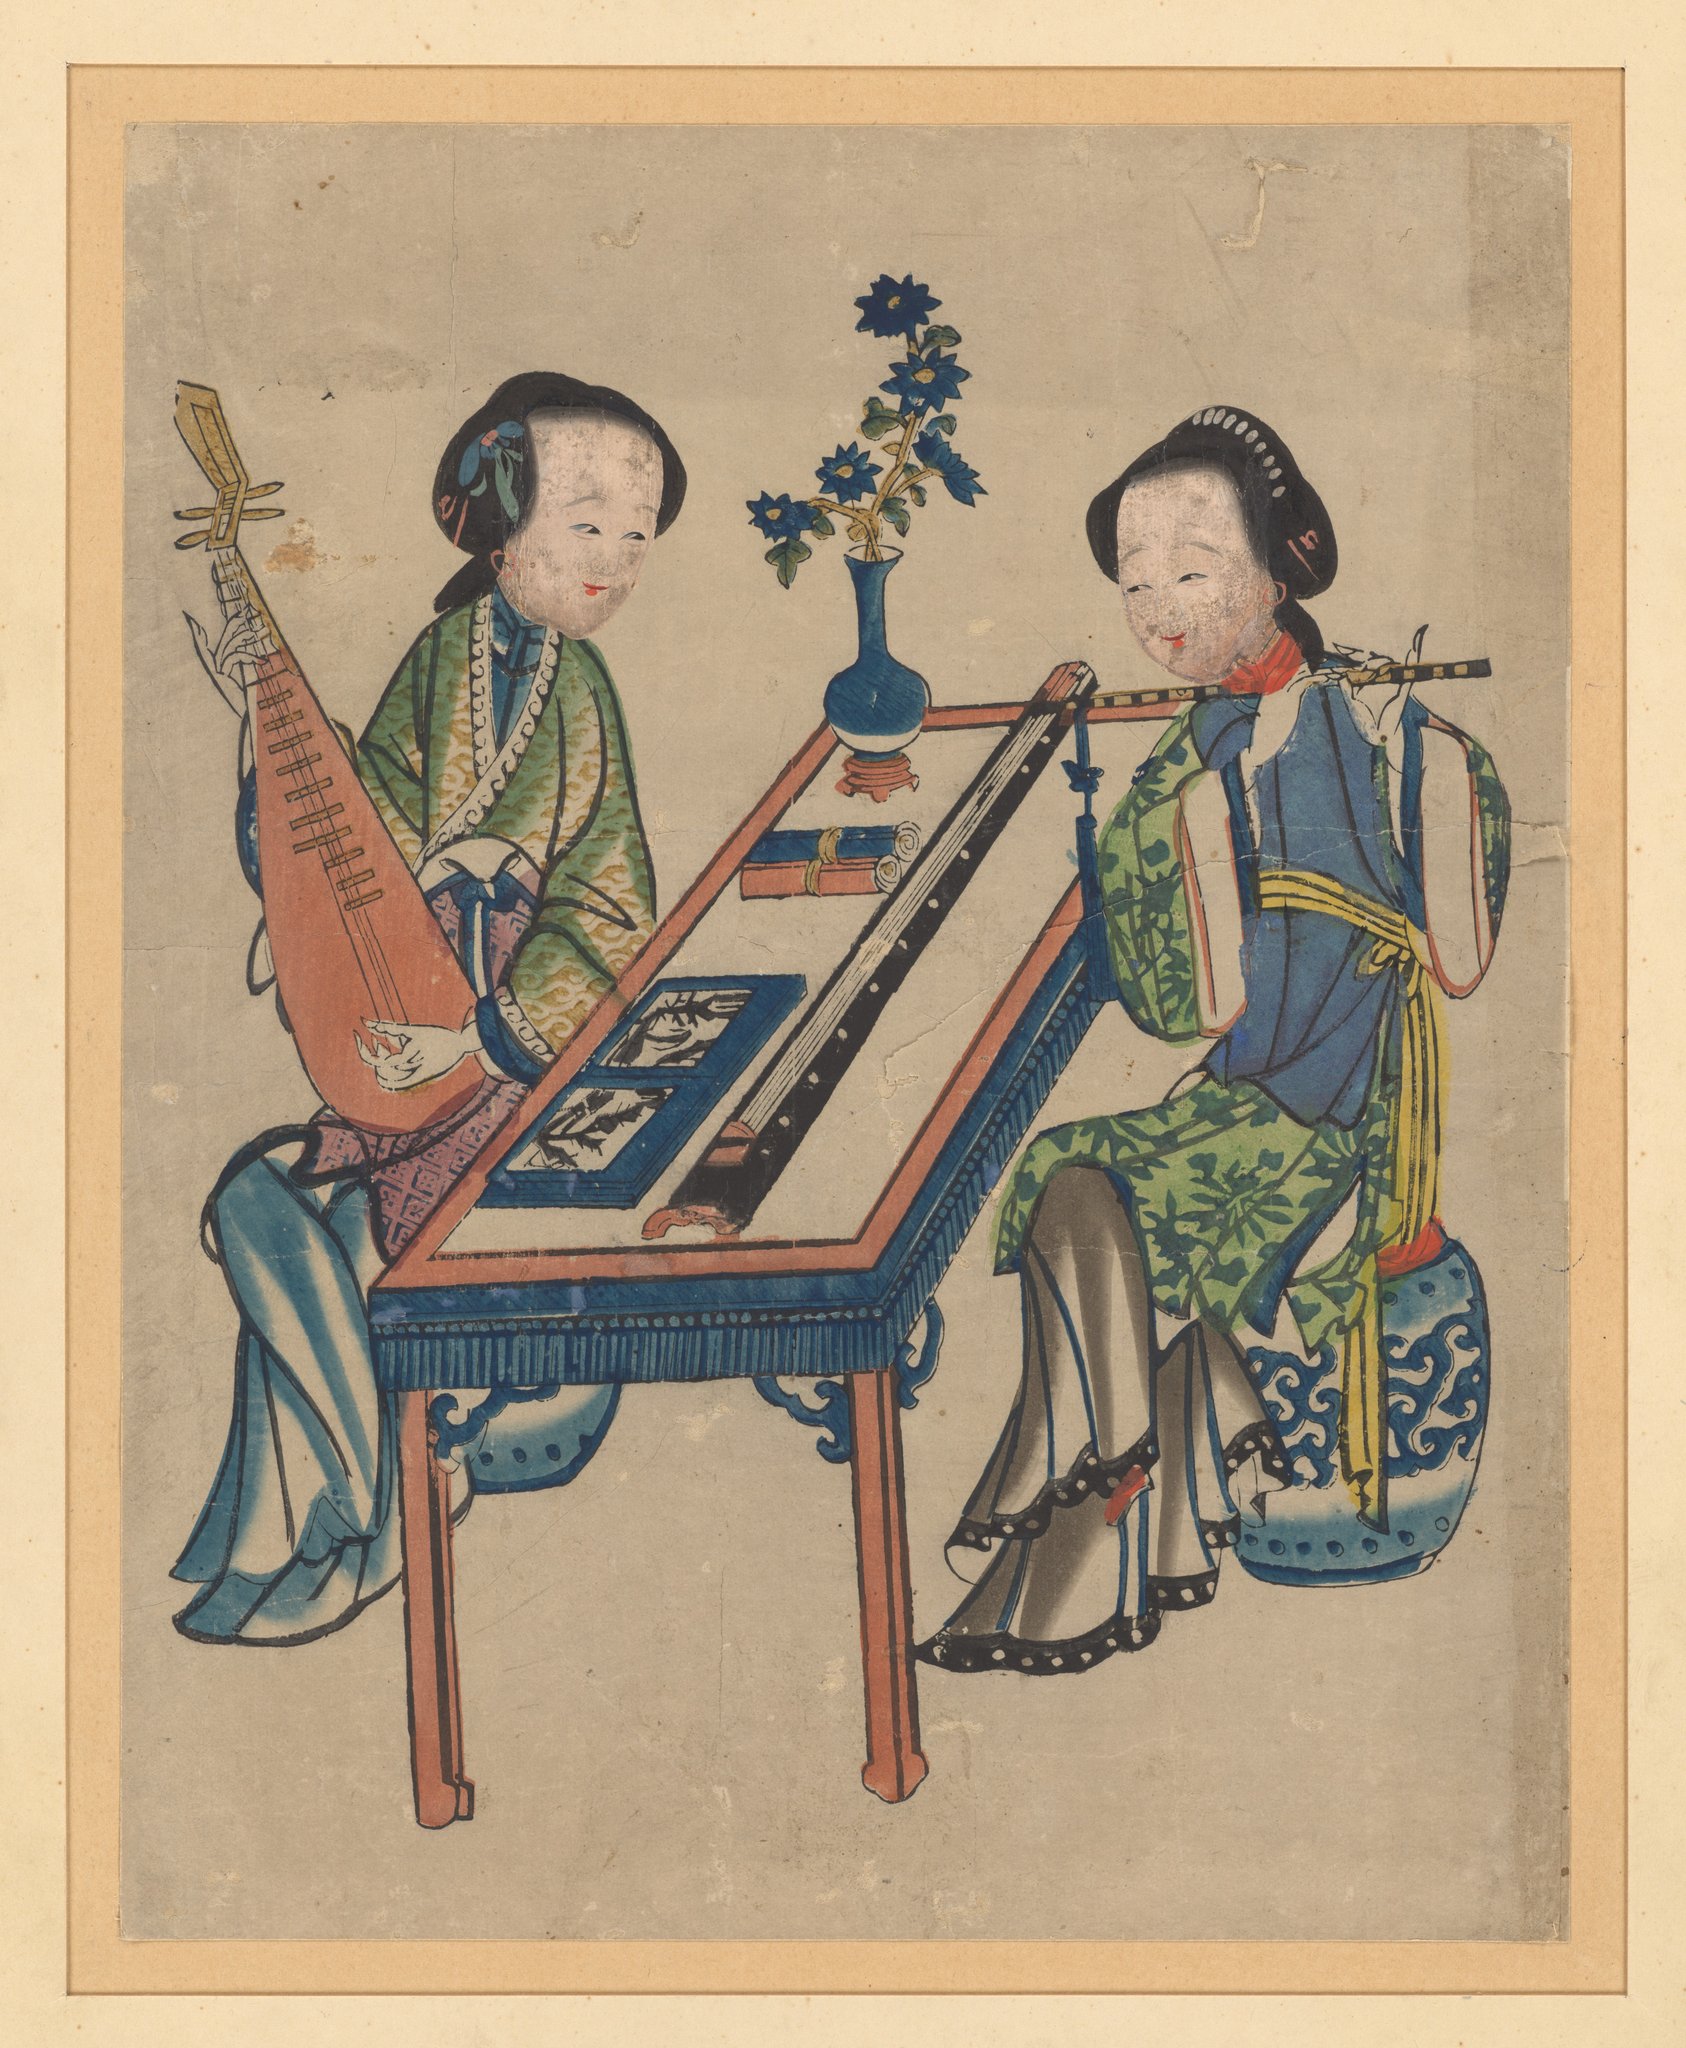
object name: print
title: Two Ladies Playing Music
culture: chinese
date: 1736-1795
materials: ink, paper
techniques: hand coloring, woodblock print